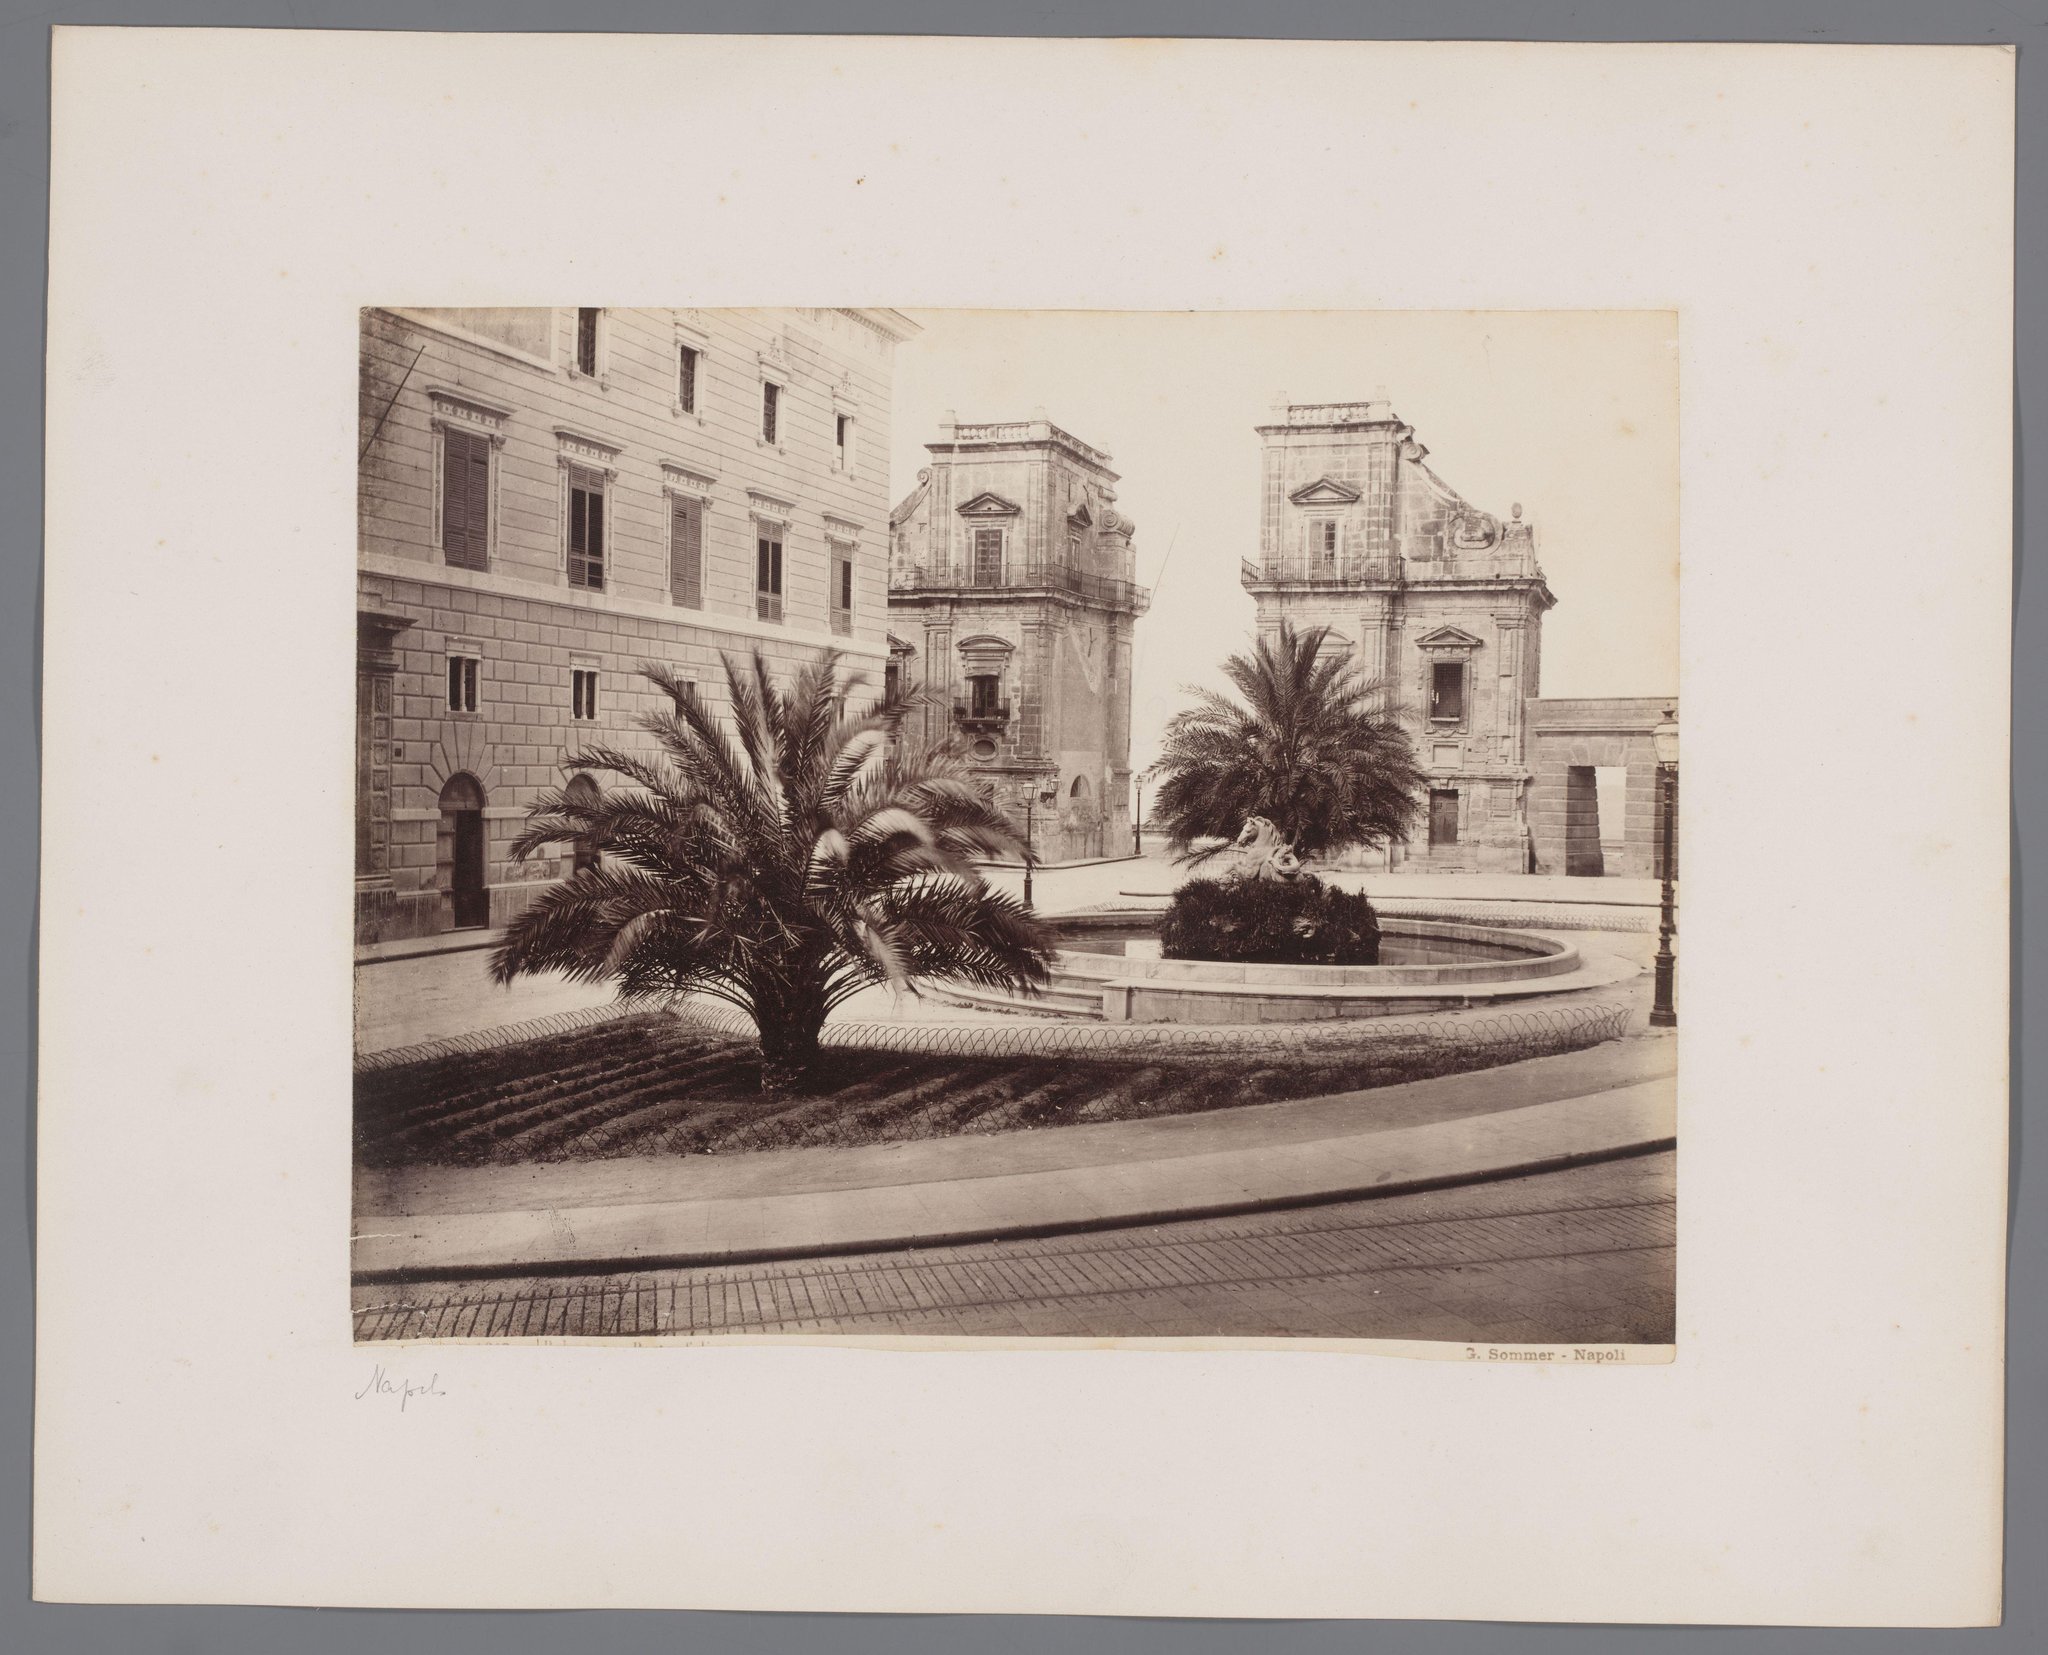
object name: photograph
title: Gezicht op een plein in Napels, Italië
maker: giorgio sommer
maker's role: fotograaf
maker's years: 1834-1914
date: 1857-1914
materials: cardboard, paper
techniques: albumen print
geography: naples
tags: square, place, circus, etc., trees: palm-tree, naples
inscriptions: number: ‘[...]’, inscription: ‘Napels’